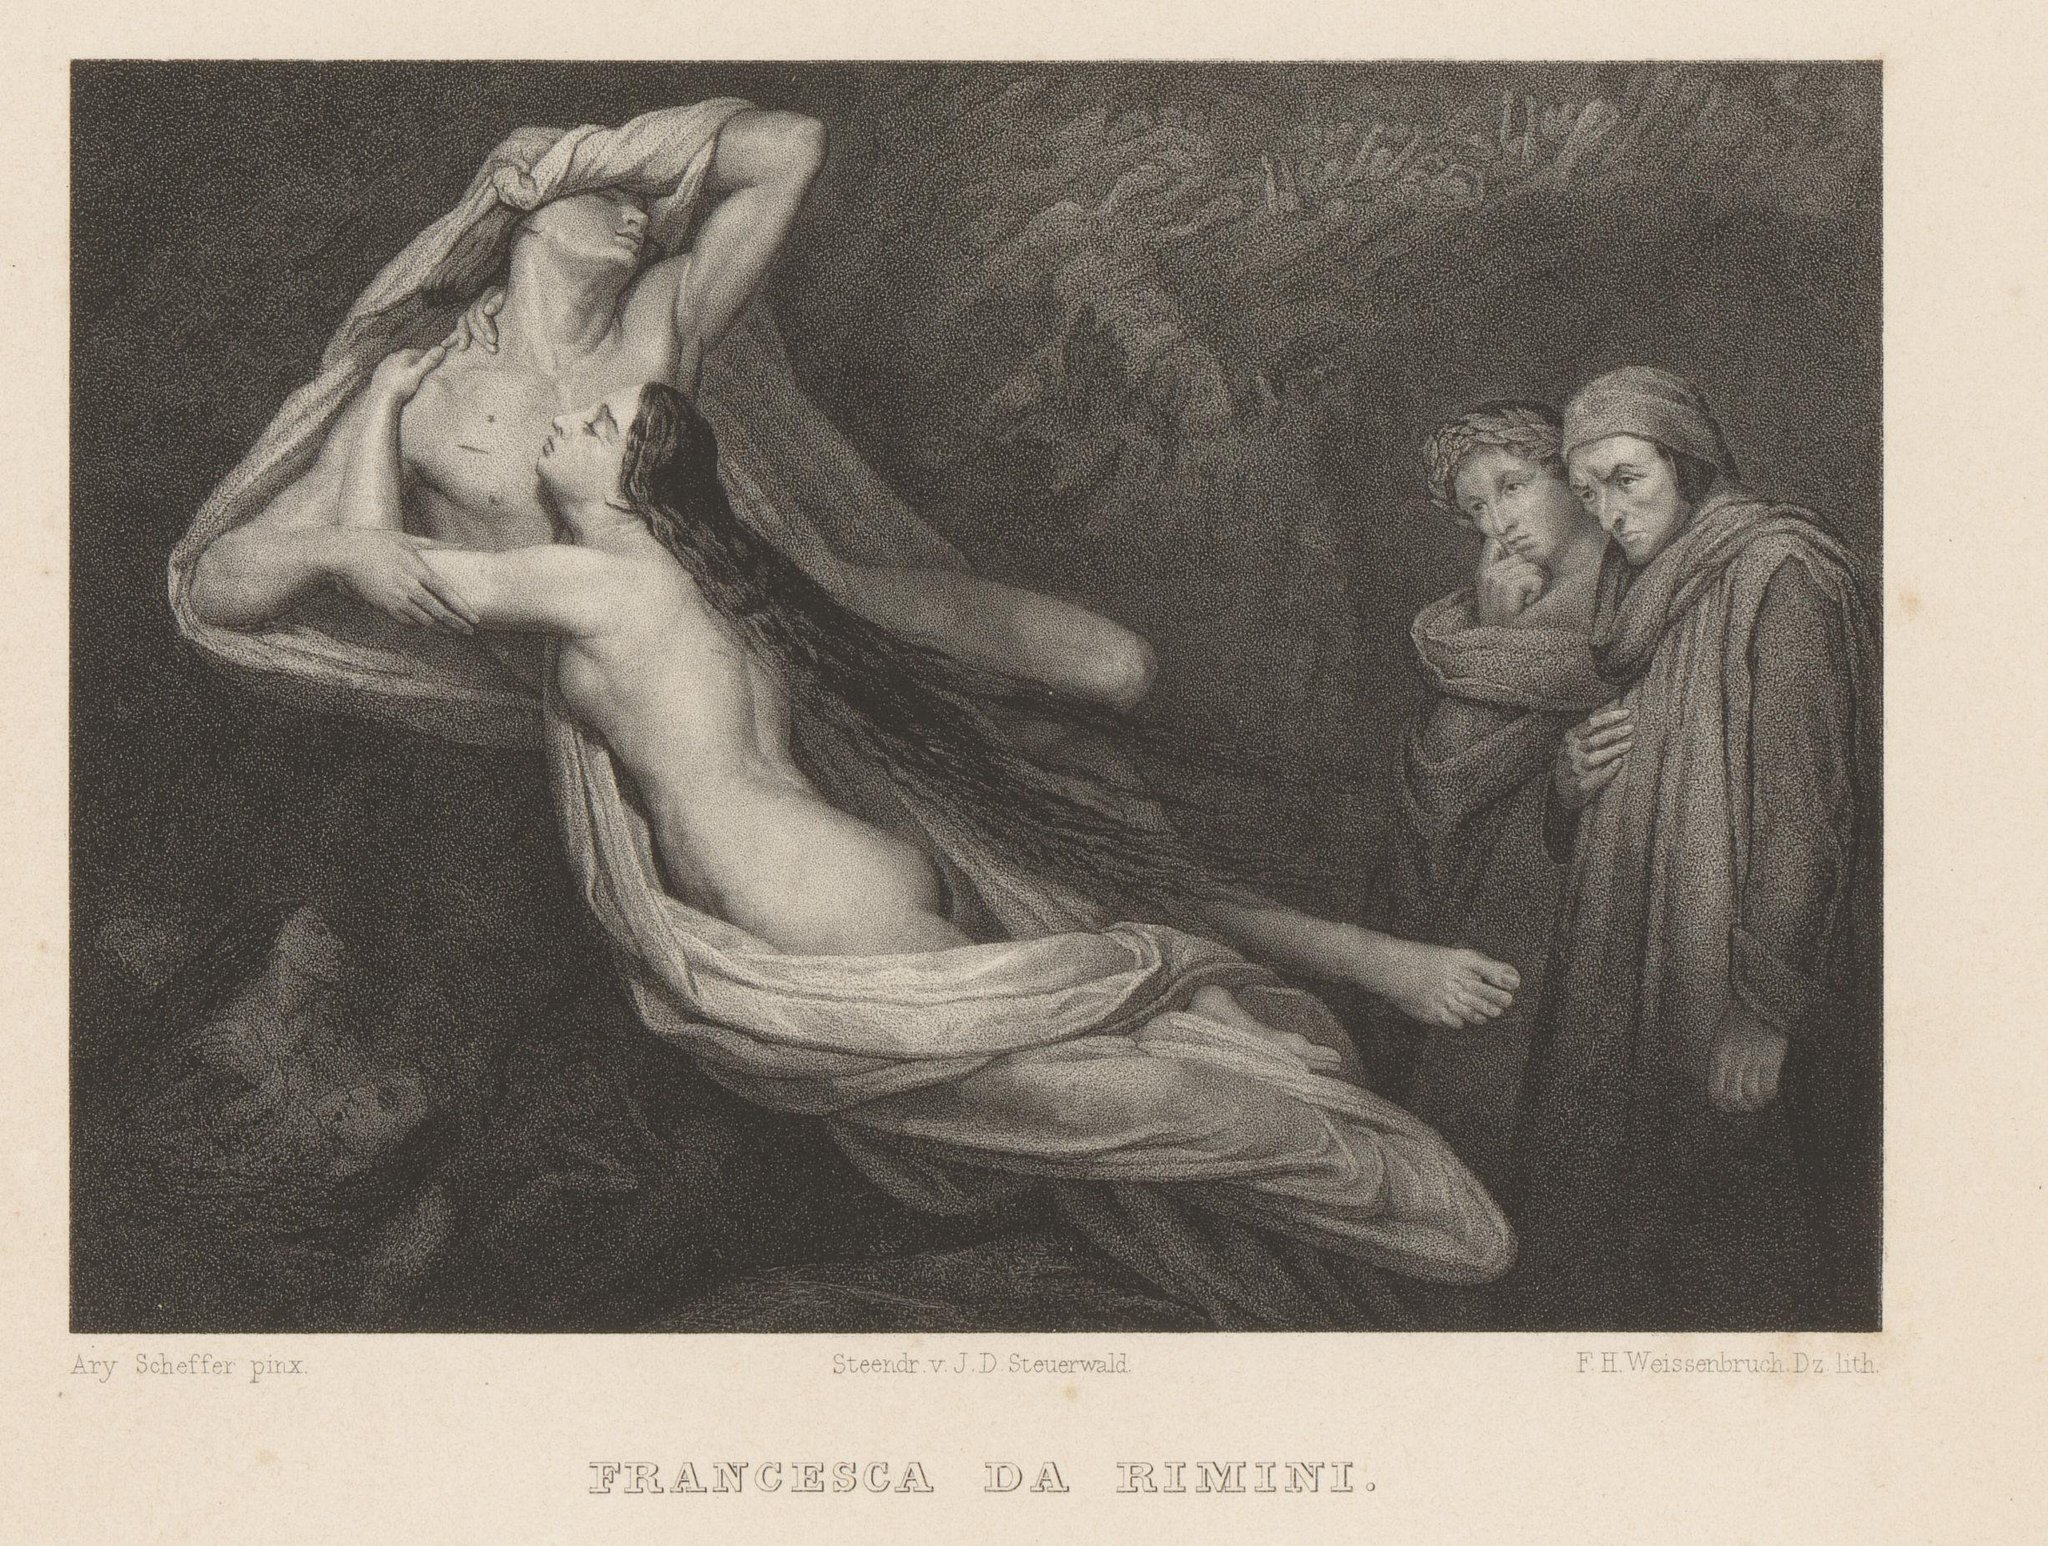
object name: print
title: Francesca da Rimini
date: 1842-1863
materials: paper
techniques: lithograph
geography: haarlem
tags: dante alighieri, politician, murder, murderer, (scenes from) specific works of literature: dante, divina commedia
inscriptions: collector's mark: Lugt 2233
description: De dode naakte lichamen van Francesca da Rimini en Paolo Malatesta stijgen op. Rechts staan Dante Alighieri en Giovanni Malatesta. Op de achtergrond dode zielen die ook opstijgen.